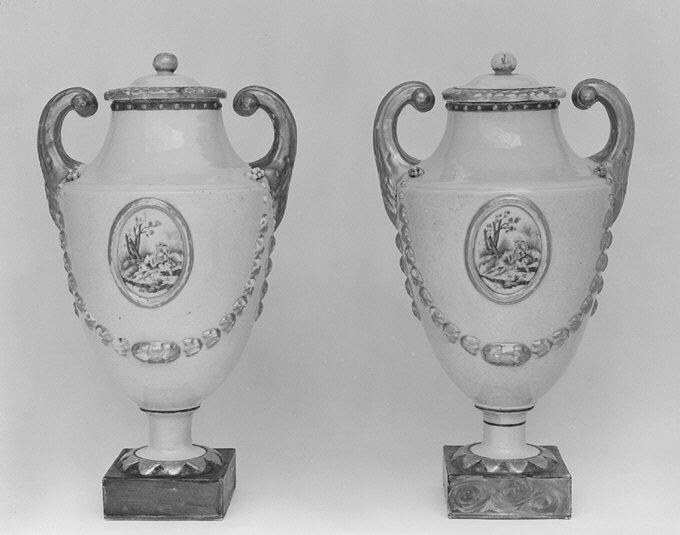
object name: urn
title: Urn (one of a pair)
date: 1775-1785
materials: hard paste porcelain